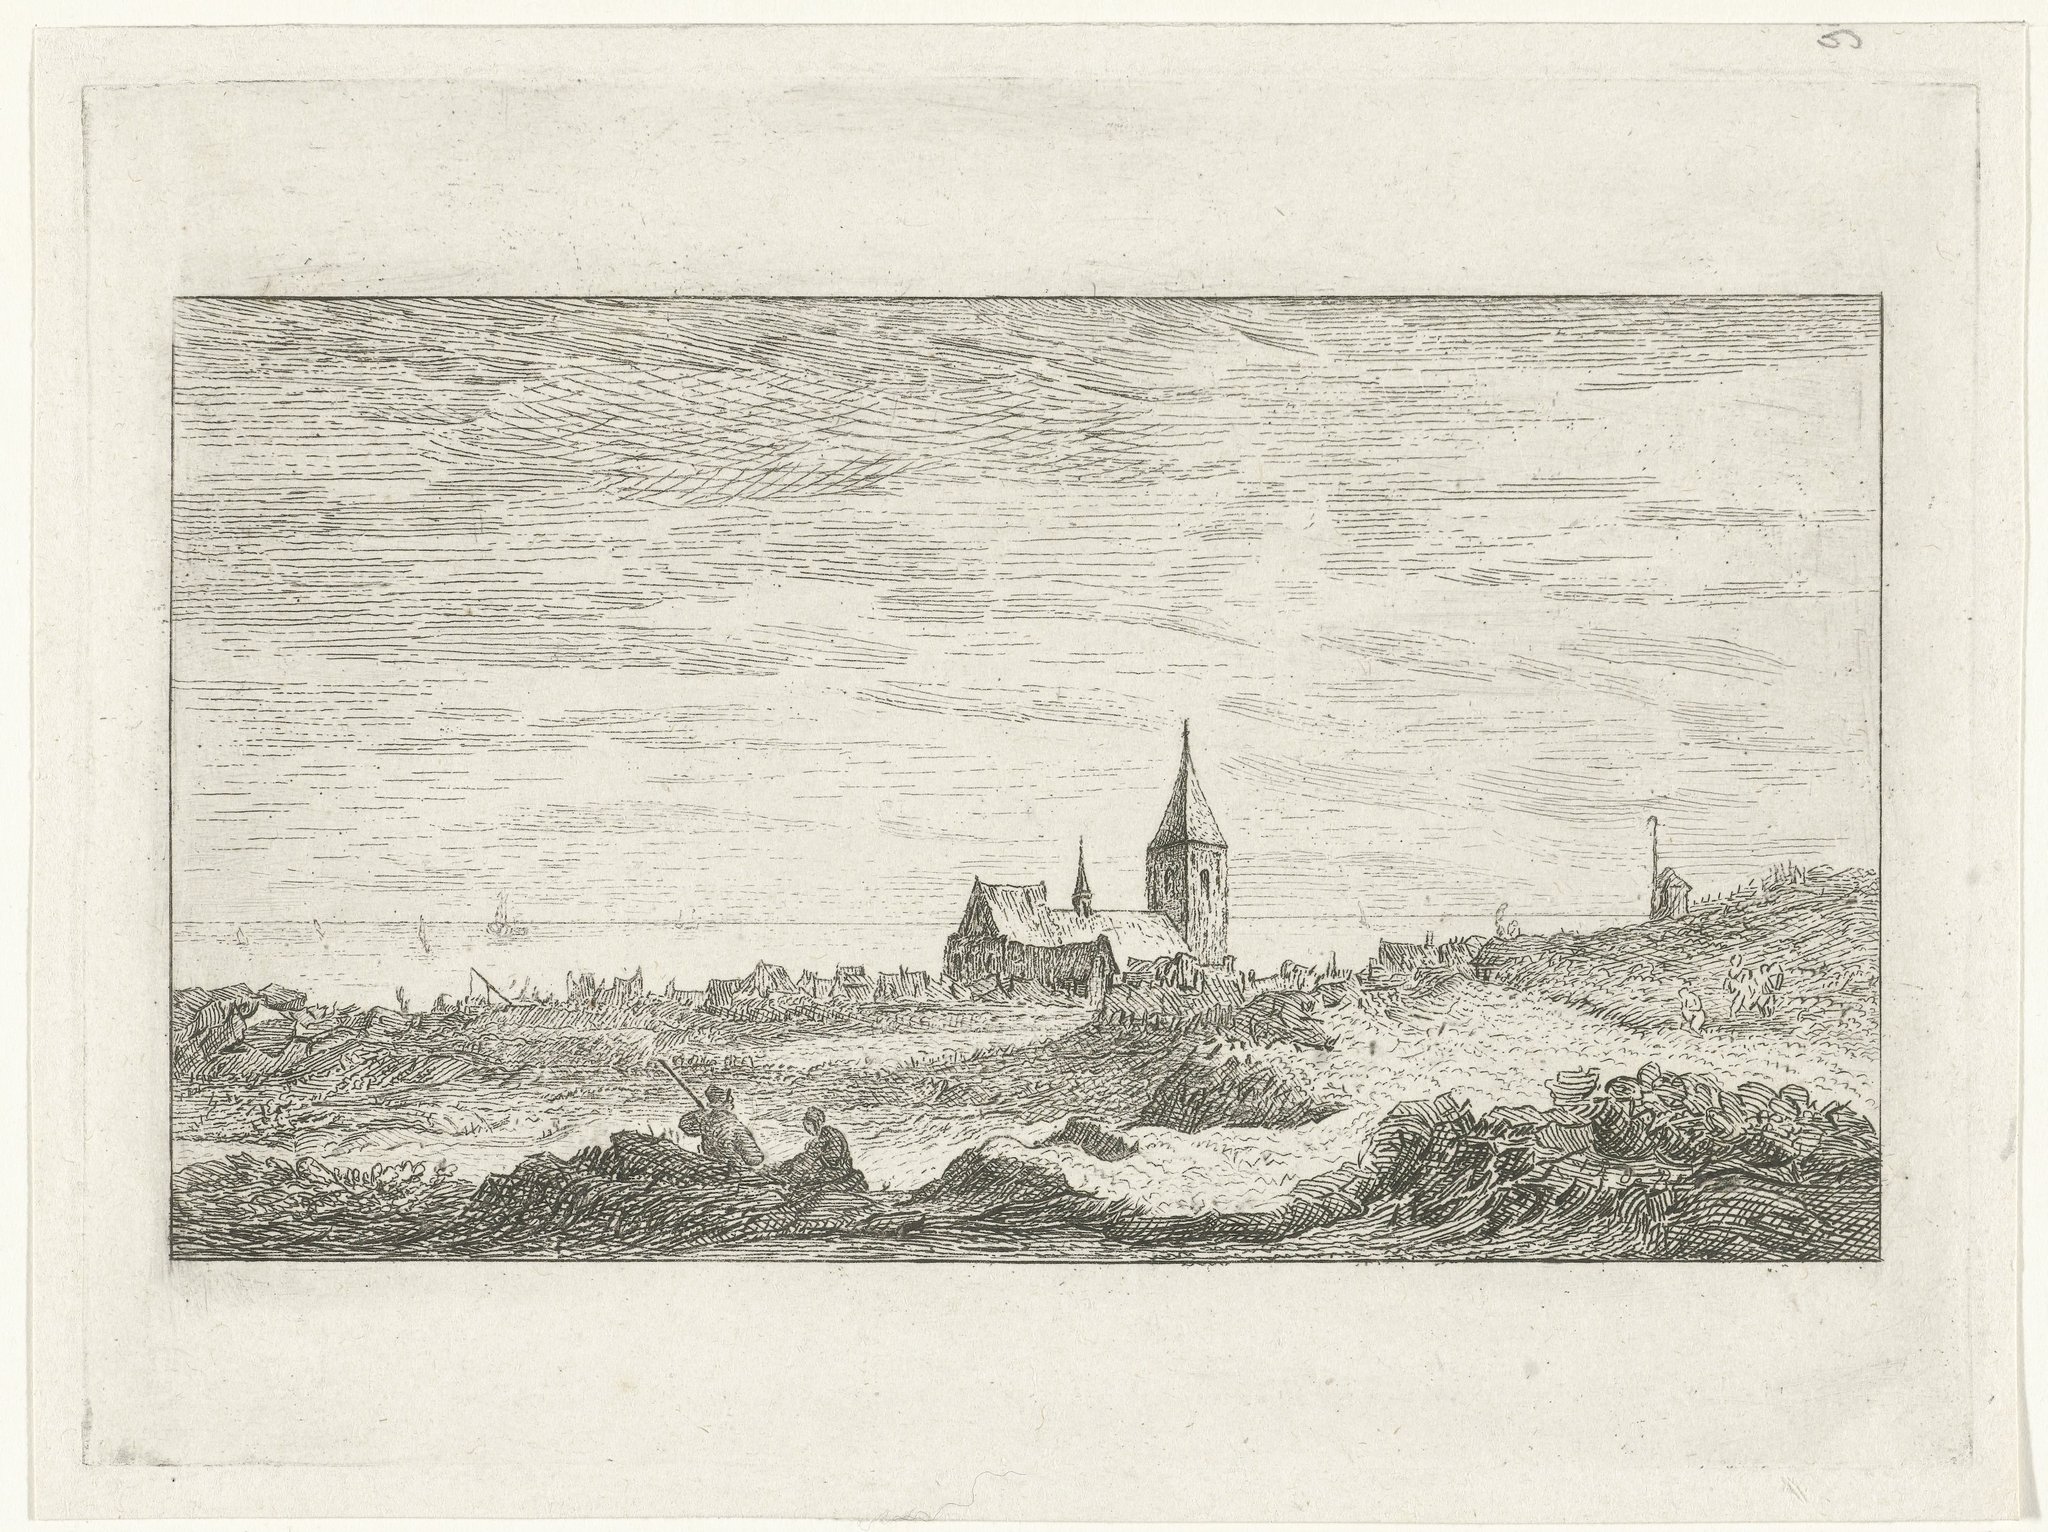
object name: print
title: Dorp aan zee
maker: reinierus albertus ludovicus baron van isendoorn à blois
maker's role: print maker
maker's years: 1786-1856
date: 1796-1856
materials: paper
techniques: etching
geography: vaassen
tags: prospect of village, silhouette of village, sea (+ landscape with figures, staffage)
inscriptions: collector's mark: Lugt 2228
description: Zicht op een dorp met een kerk, daarachter de zee. Op de voorgrond een zittende man en vrouw.